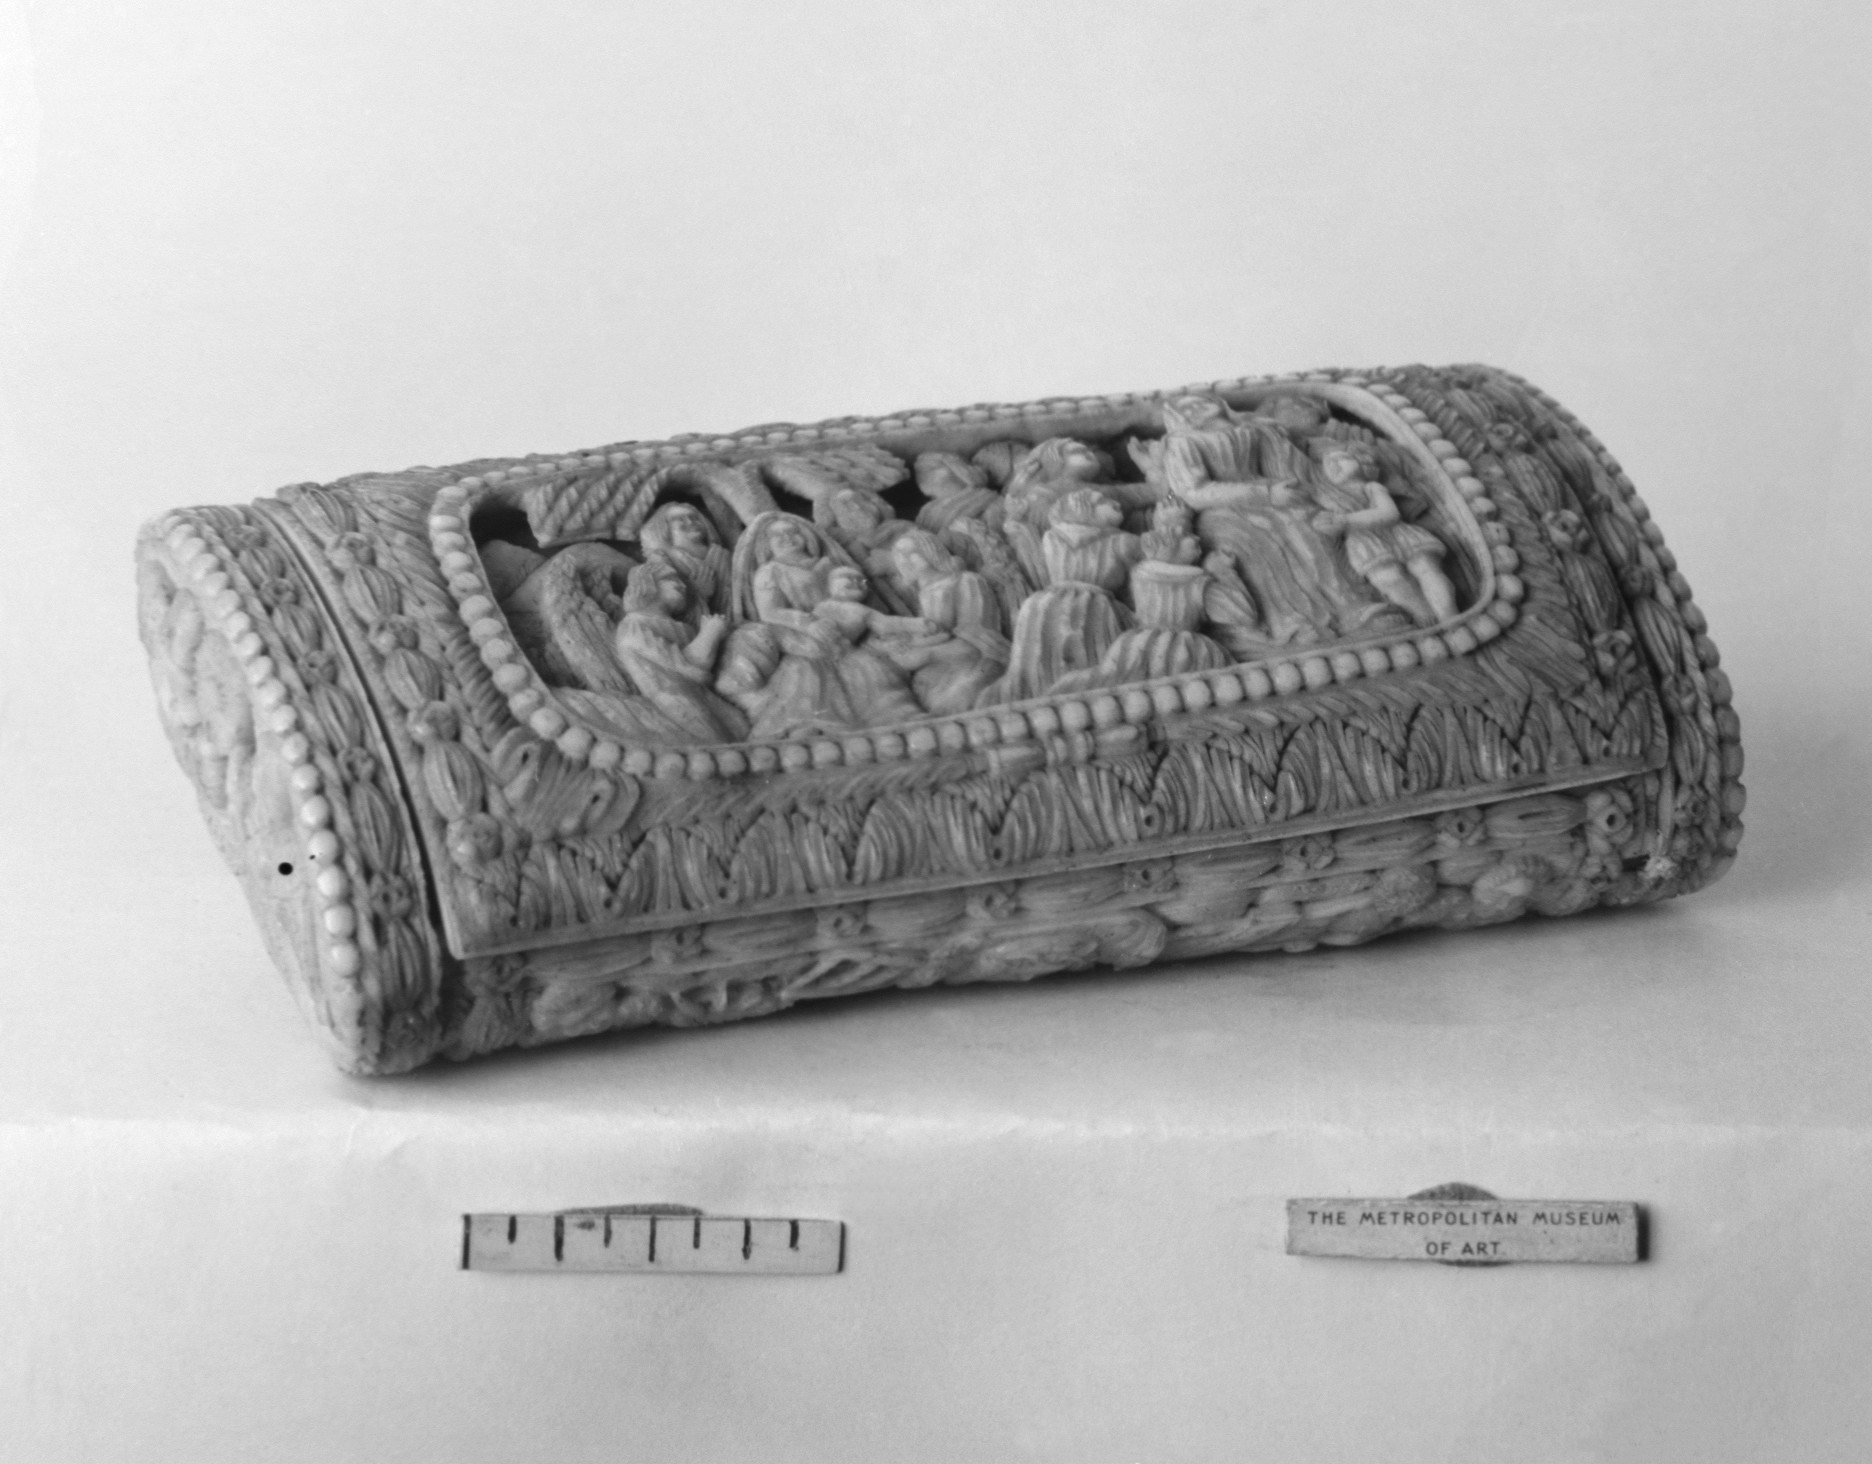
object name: box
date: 1701-1800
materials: bone, ivory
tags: women,madonna and child